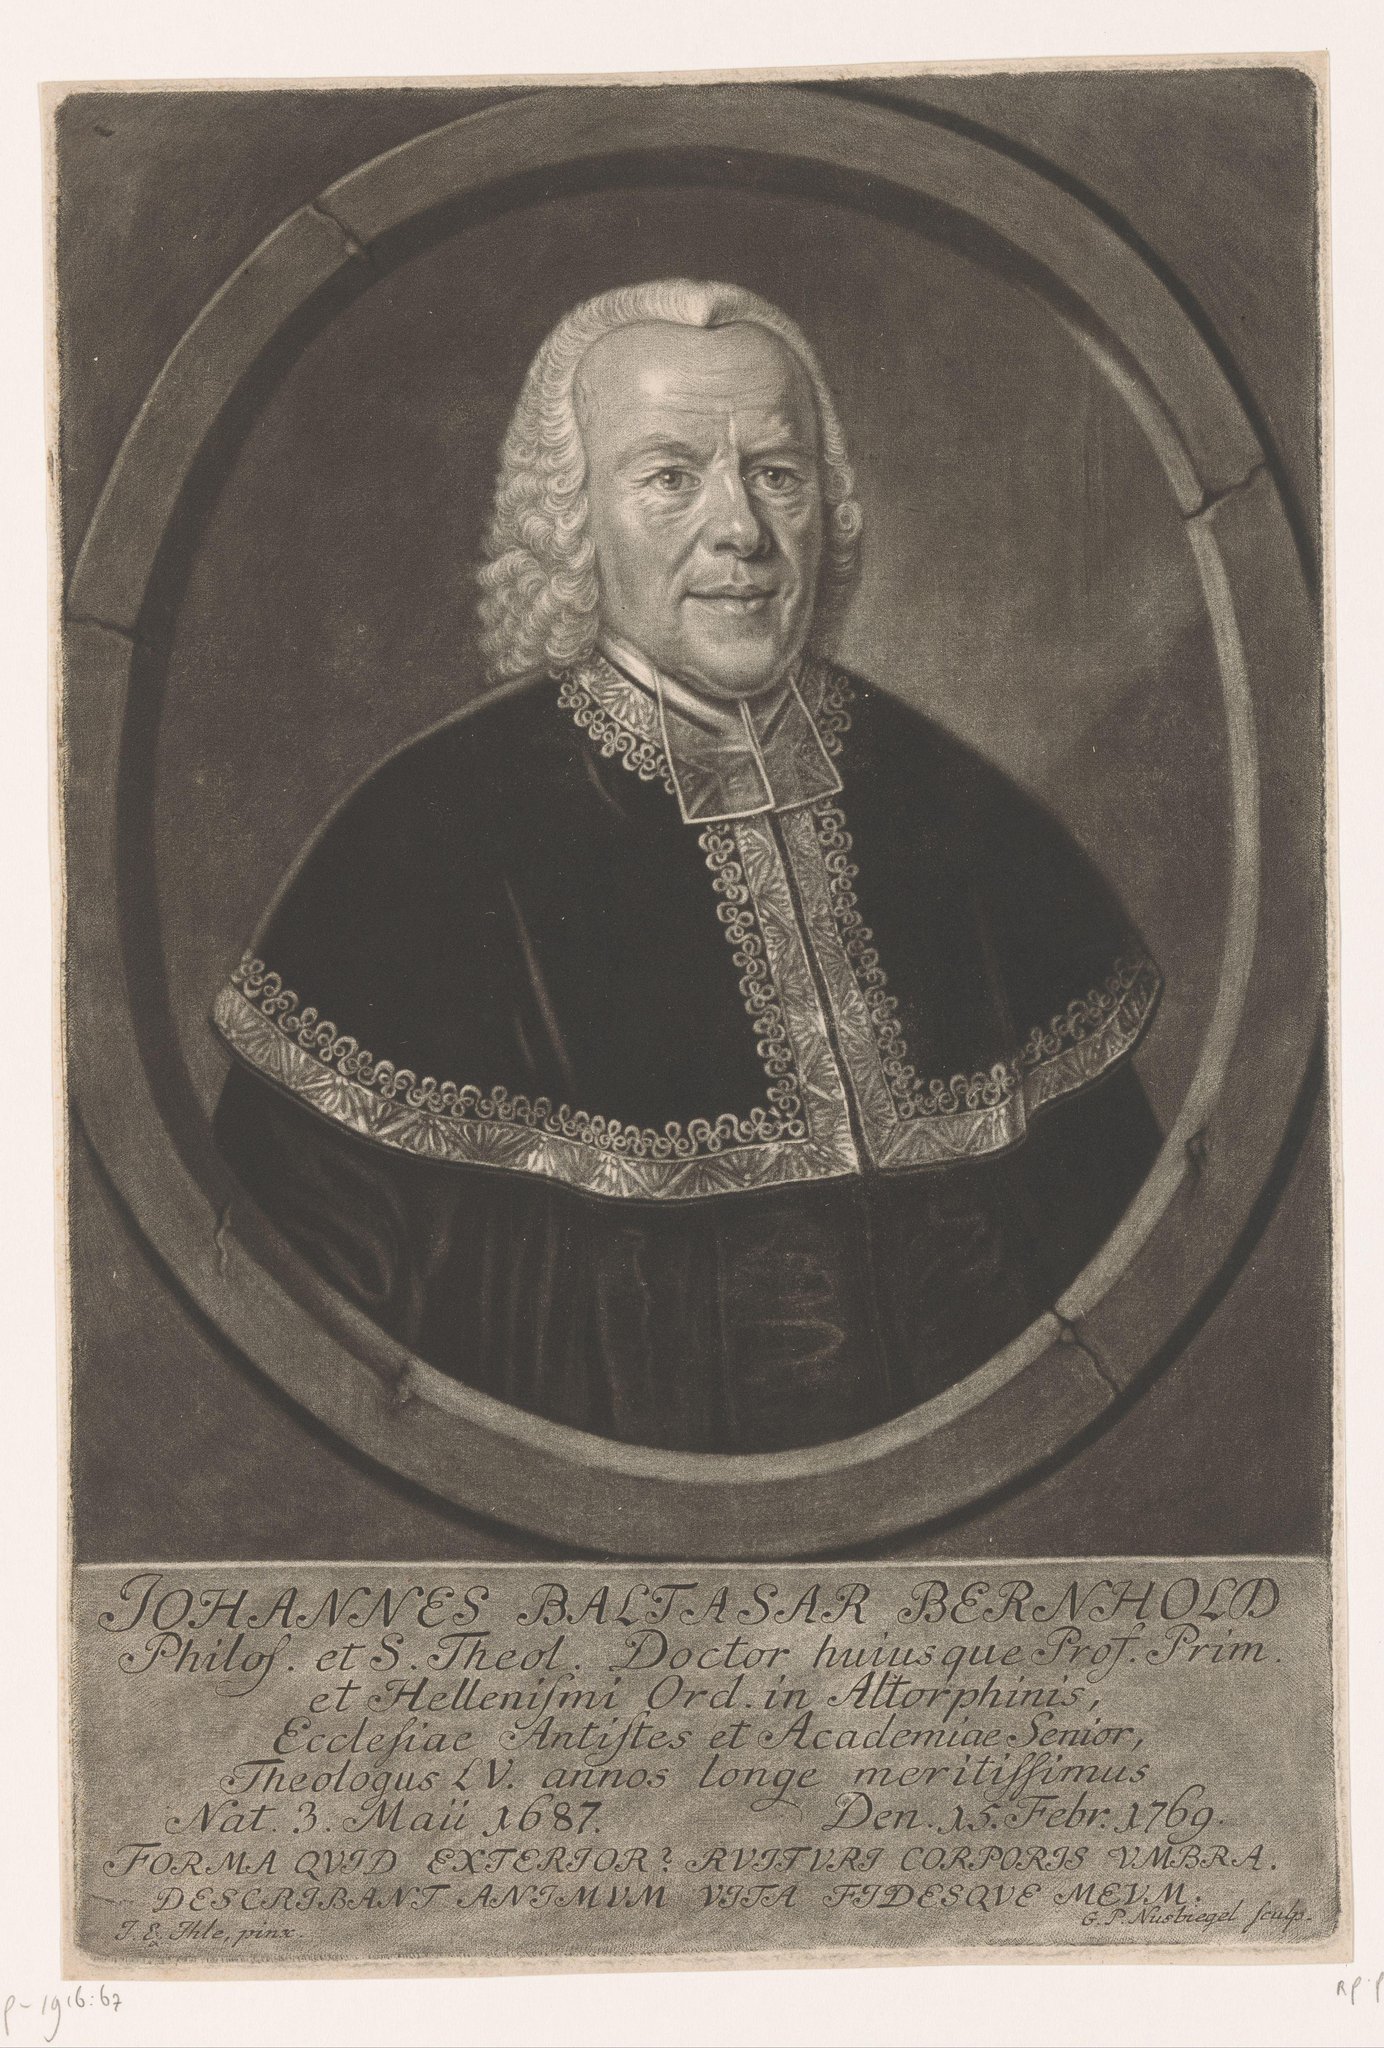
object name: print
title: Portret van Johann Balthasar Bernhold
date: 1769-1776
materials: paper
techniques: mezzotint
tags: historical persons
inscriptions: collector's mark: Lugt 2228